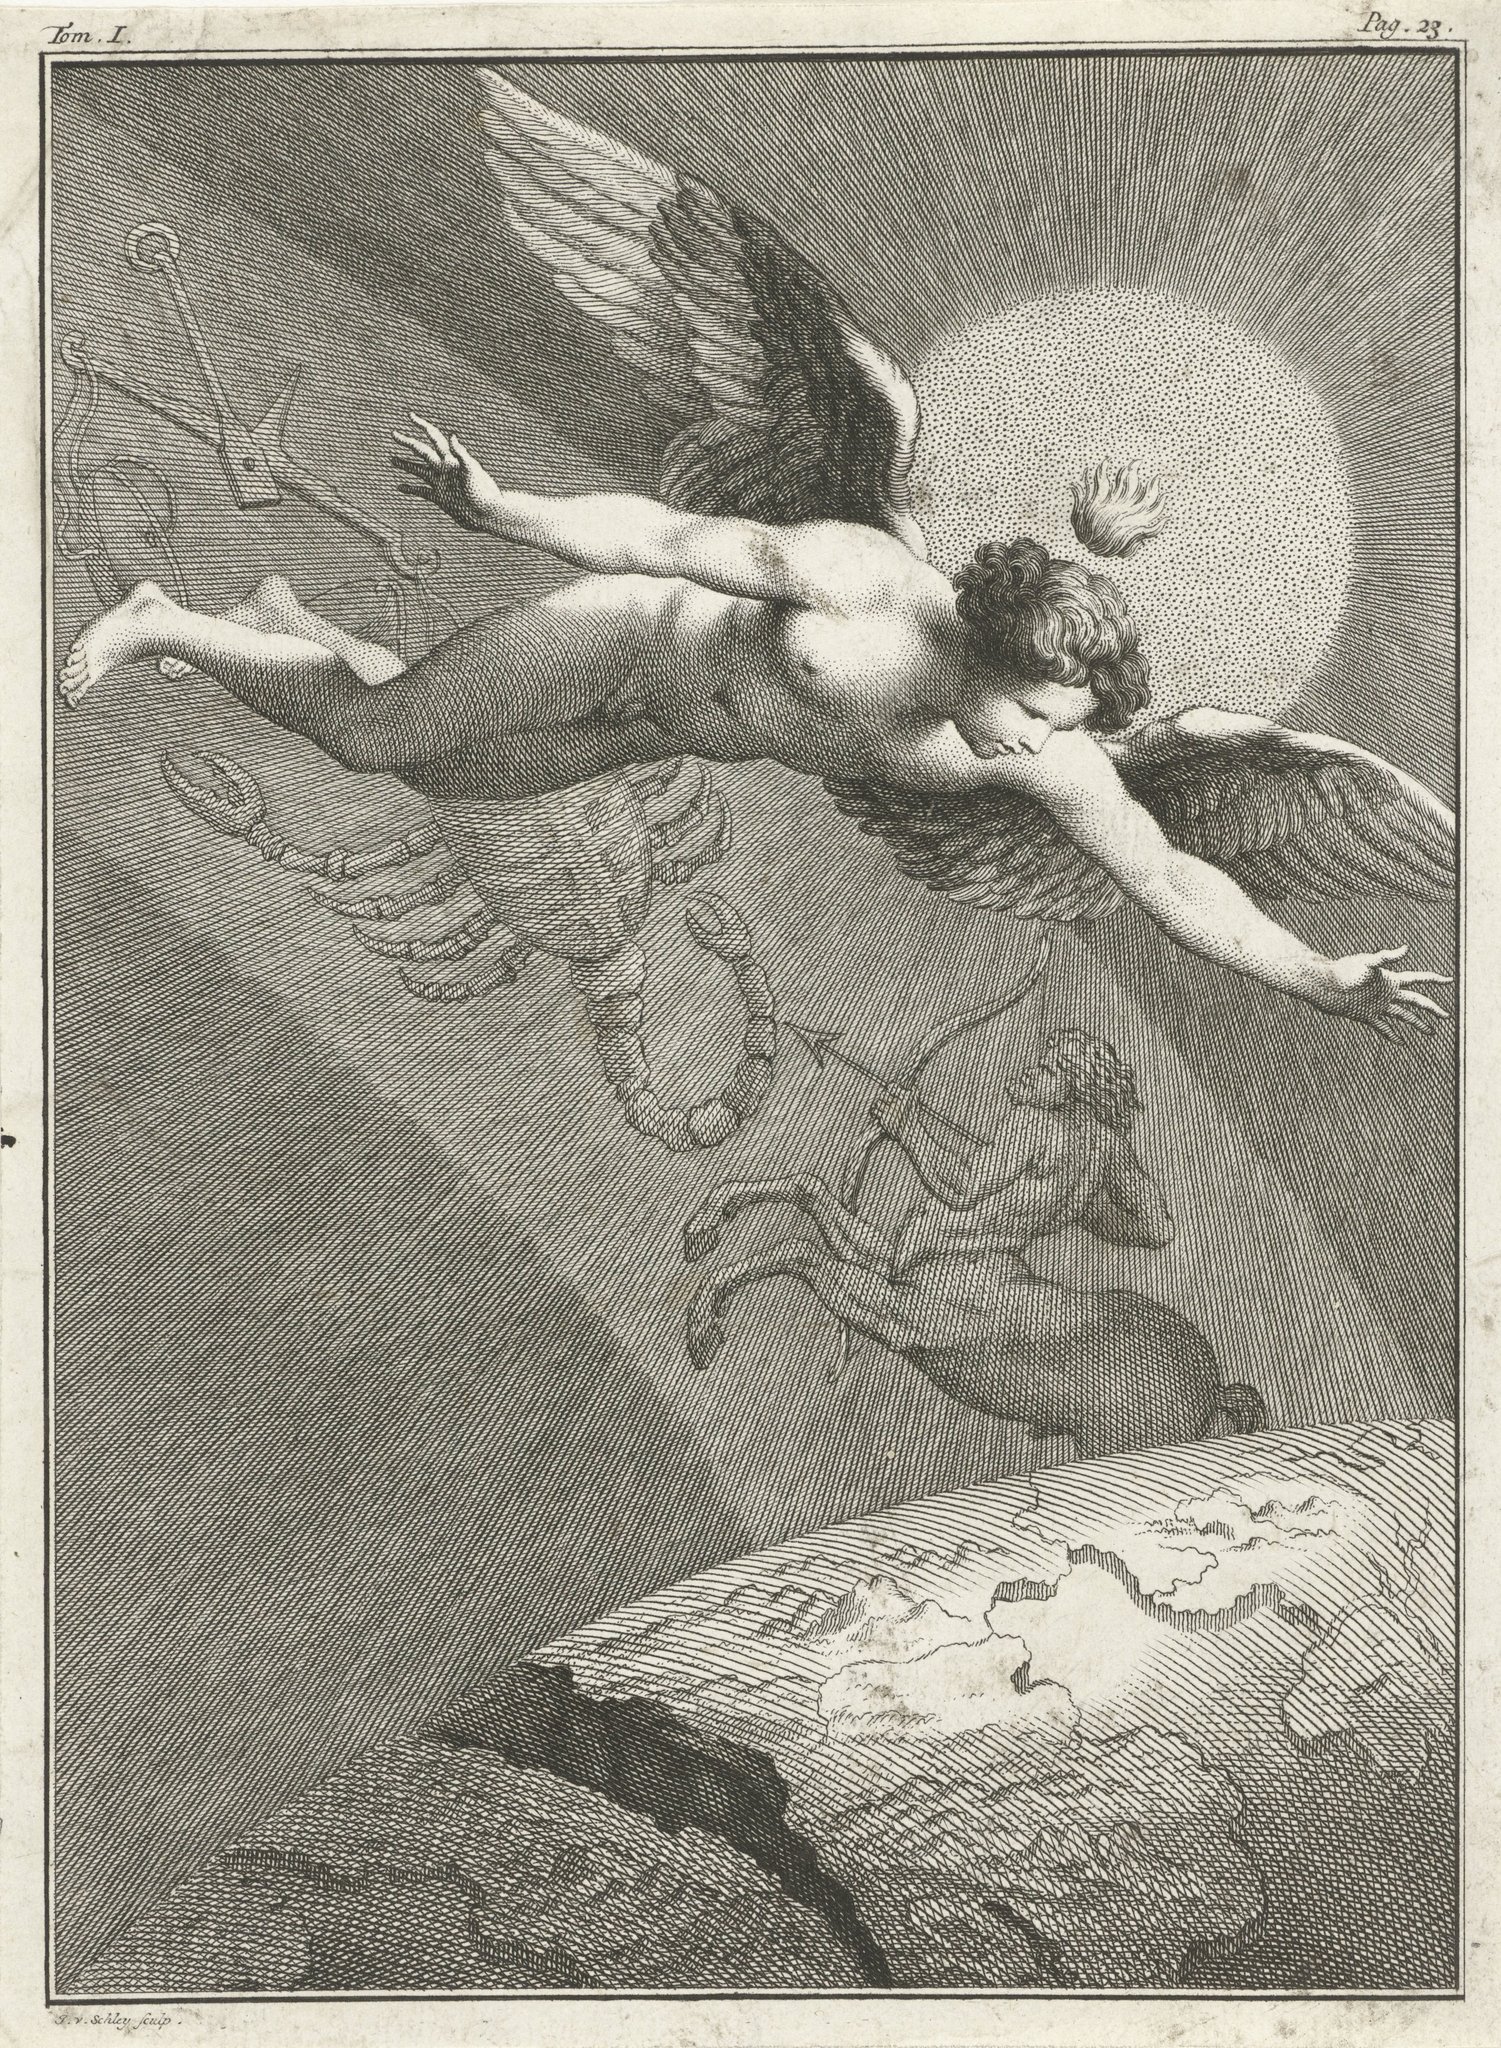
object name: print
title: Apollo en de dierenriem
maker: jacob van der schley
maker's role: draughtsman, print maker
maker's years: 1715-1779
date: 1725-1779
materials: paper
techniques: engraving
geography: amsterdam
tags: (story of) apollo (phoebus), zodiacal signs of the autumn season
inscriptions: collector's mark: Lugt 2228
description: In het heelal zweeft Apollo boven de aarde. Op de achtergrond is een deel van de dierenriem te zien; de weegschaal, schorpioen en de boogschutter.